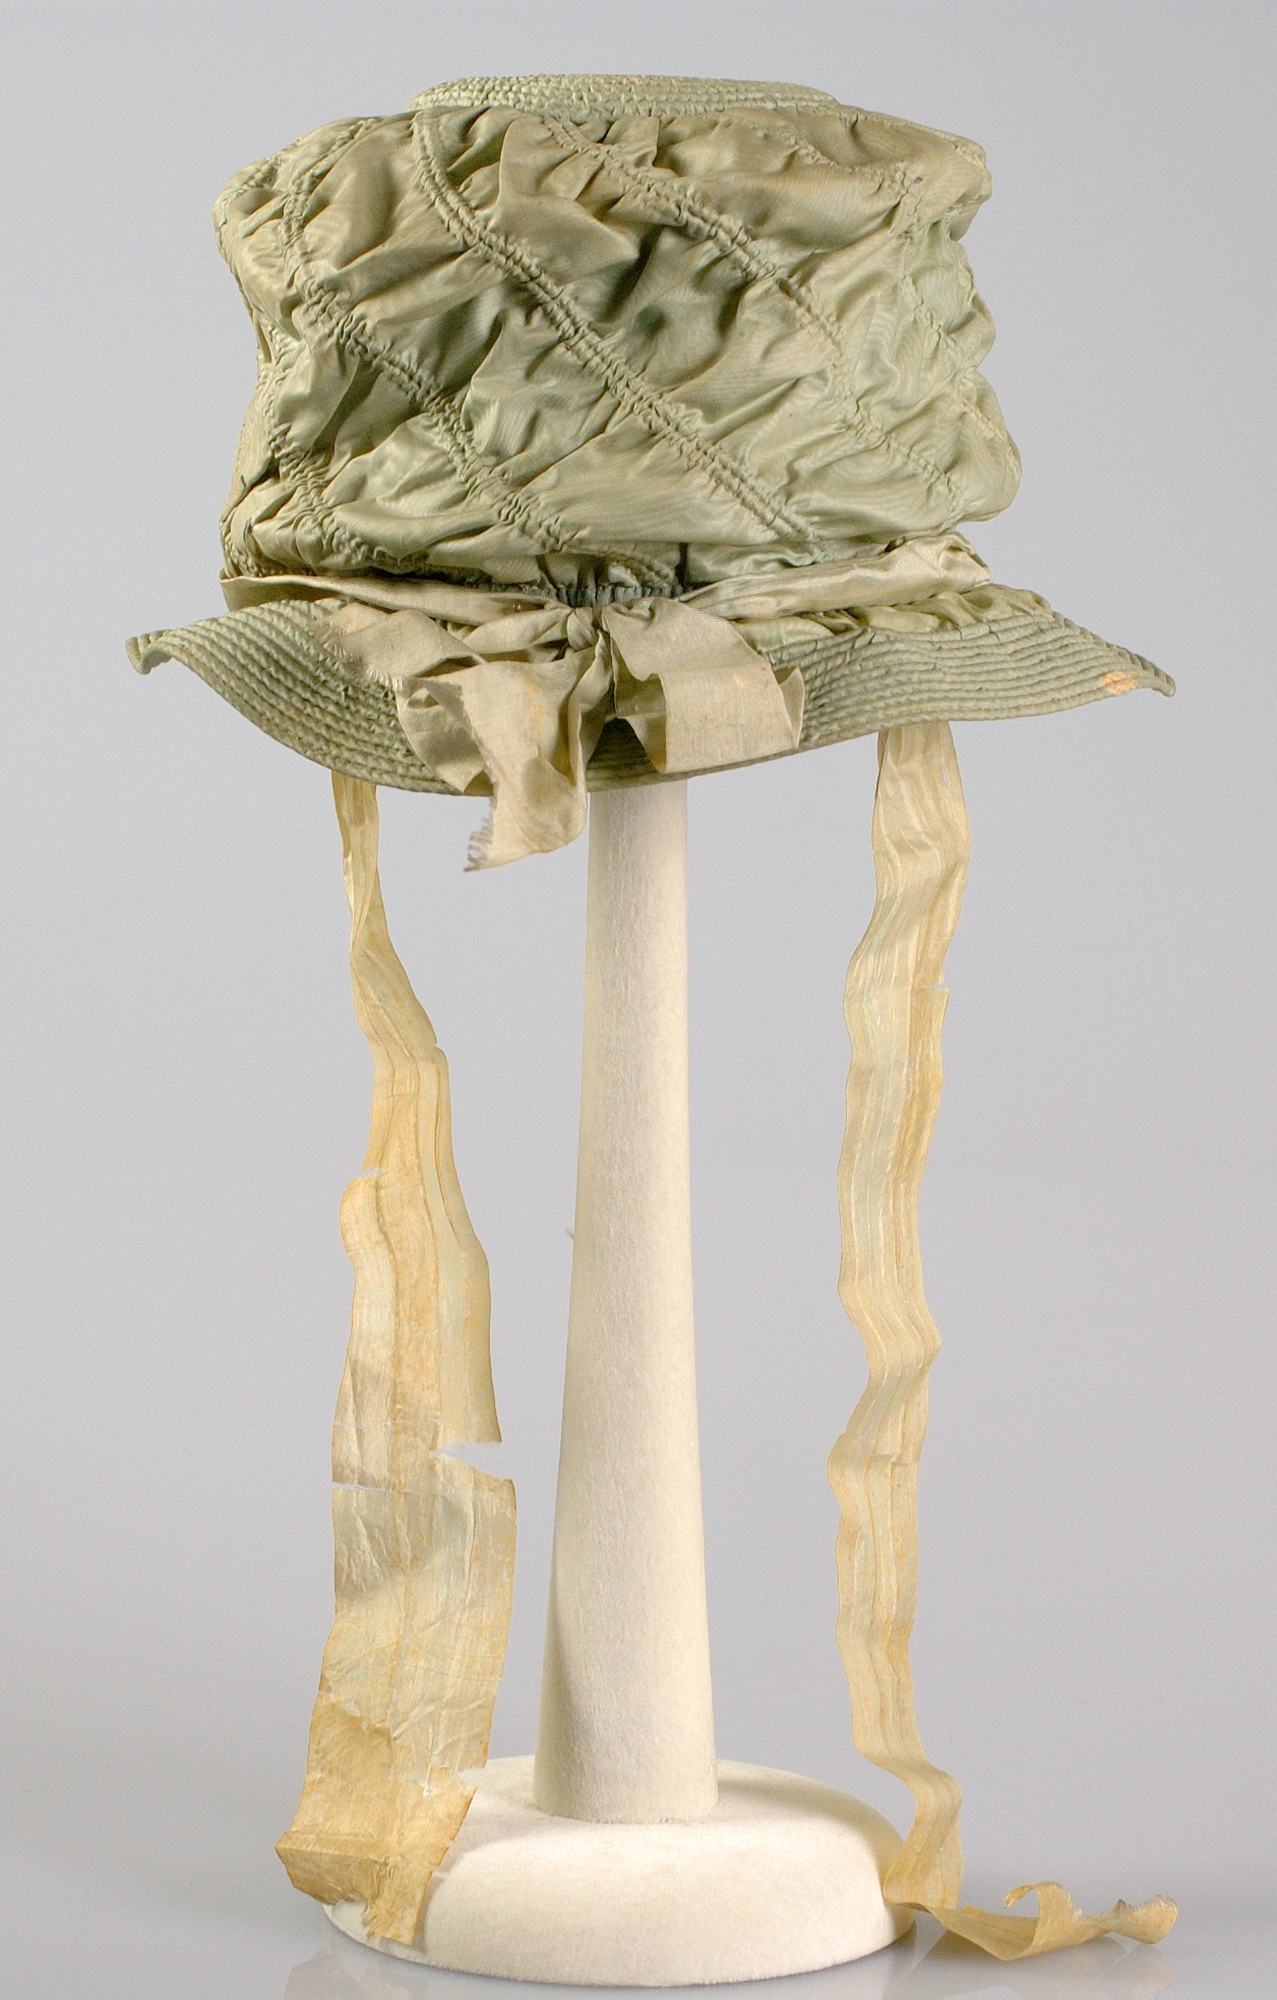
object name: hat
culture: american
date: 1820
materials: silk